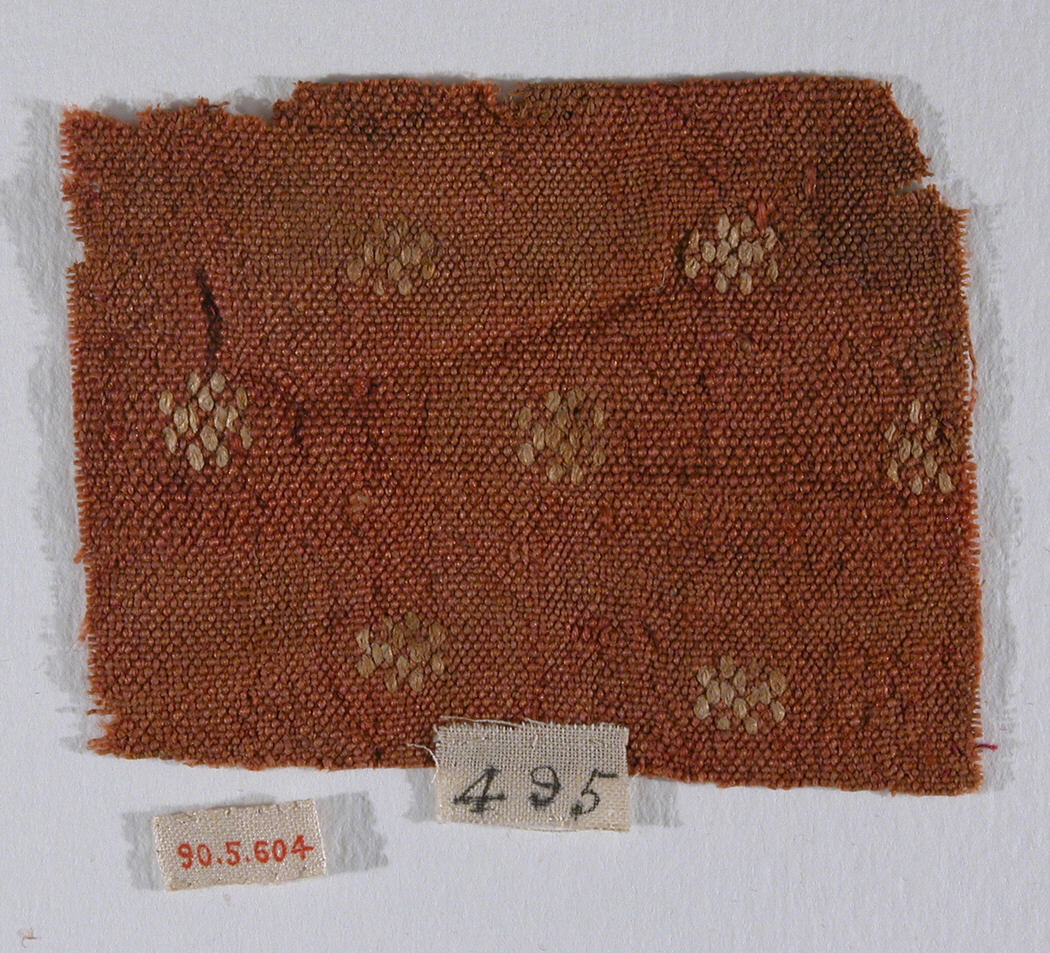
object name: textile fragment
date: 501-600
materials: linen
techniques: embroidery, weave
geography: egypt